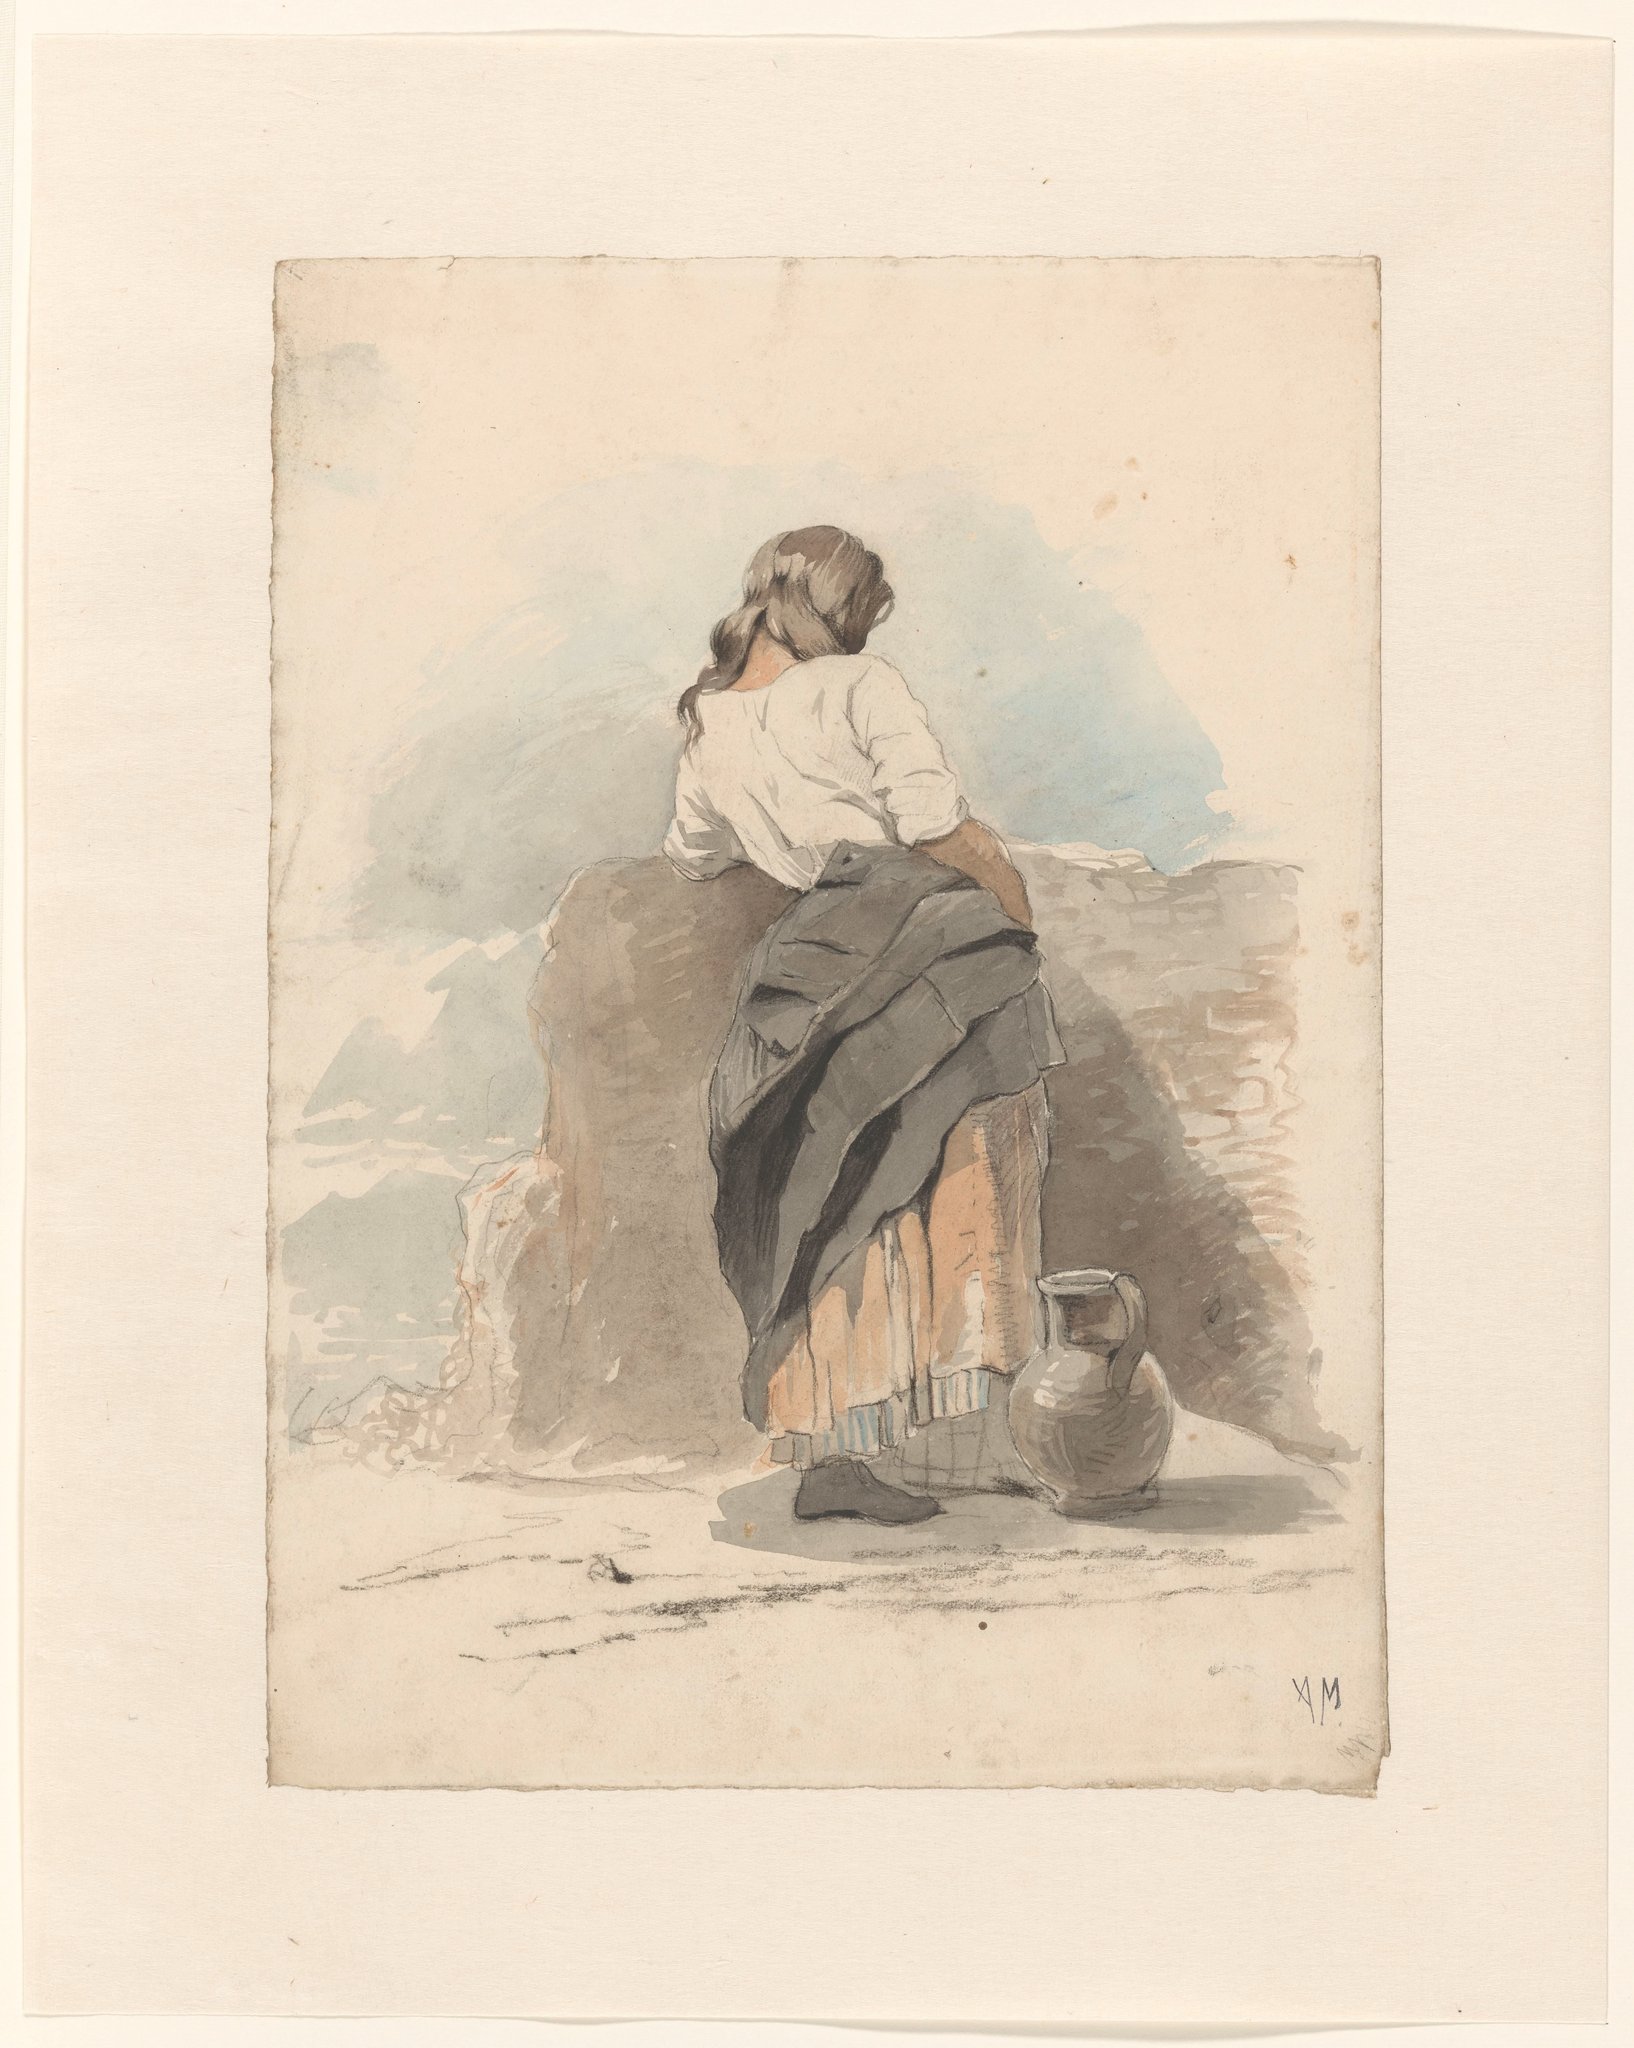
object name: drawing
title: Staande jonge vrouw bij een muur, op de rug gezien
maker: anton mauve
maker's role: draughtsman, painter, print maker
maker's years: 1838-1888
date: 1848-1888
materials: chalk, paper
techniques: brush